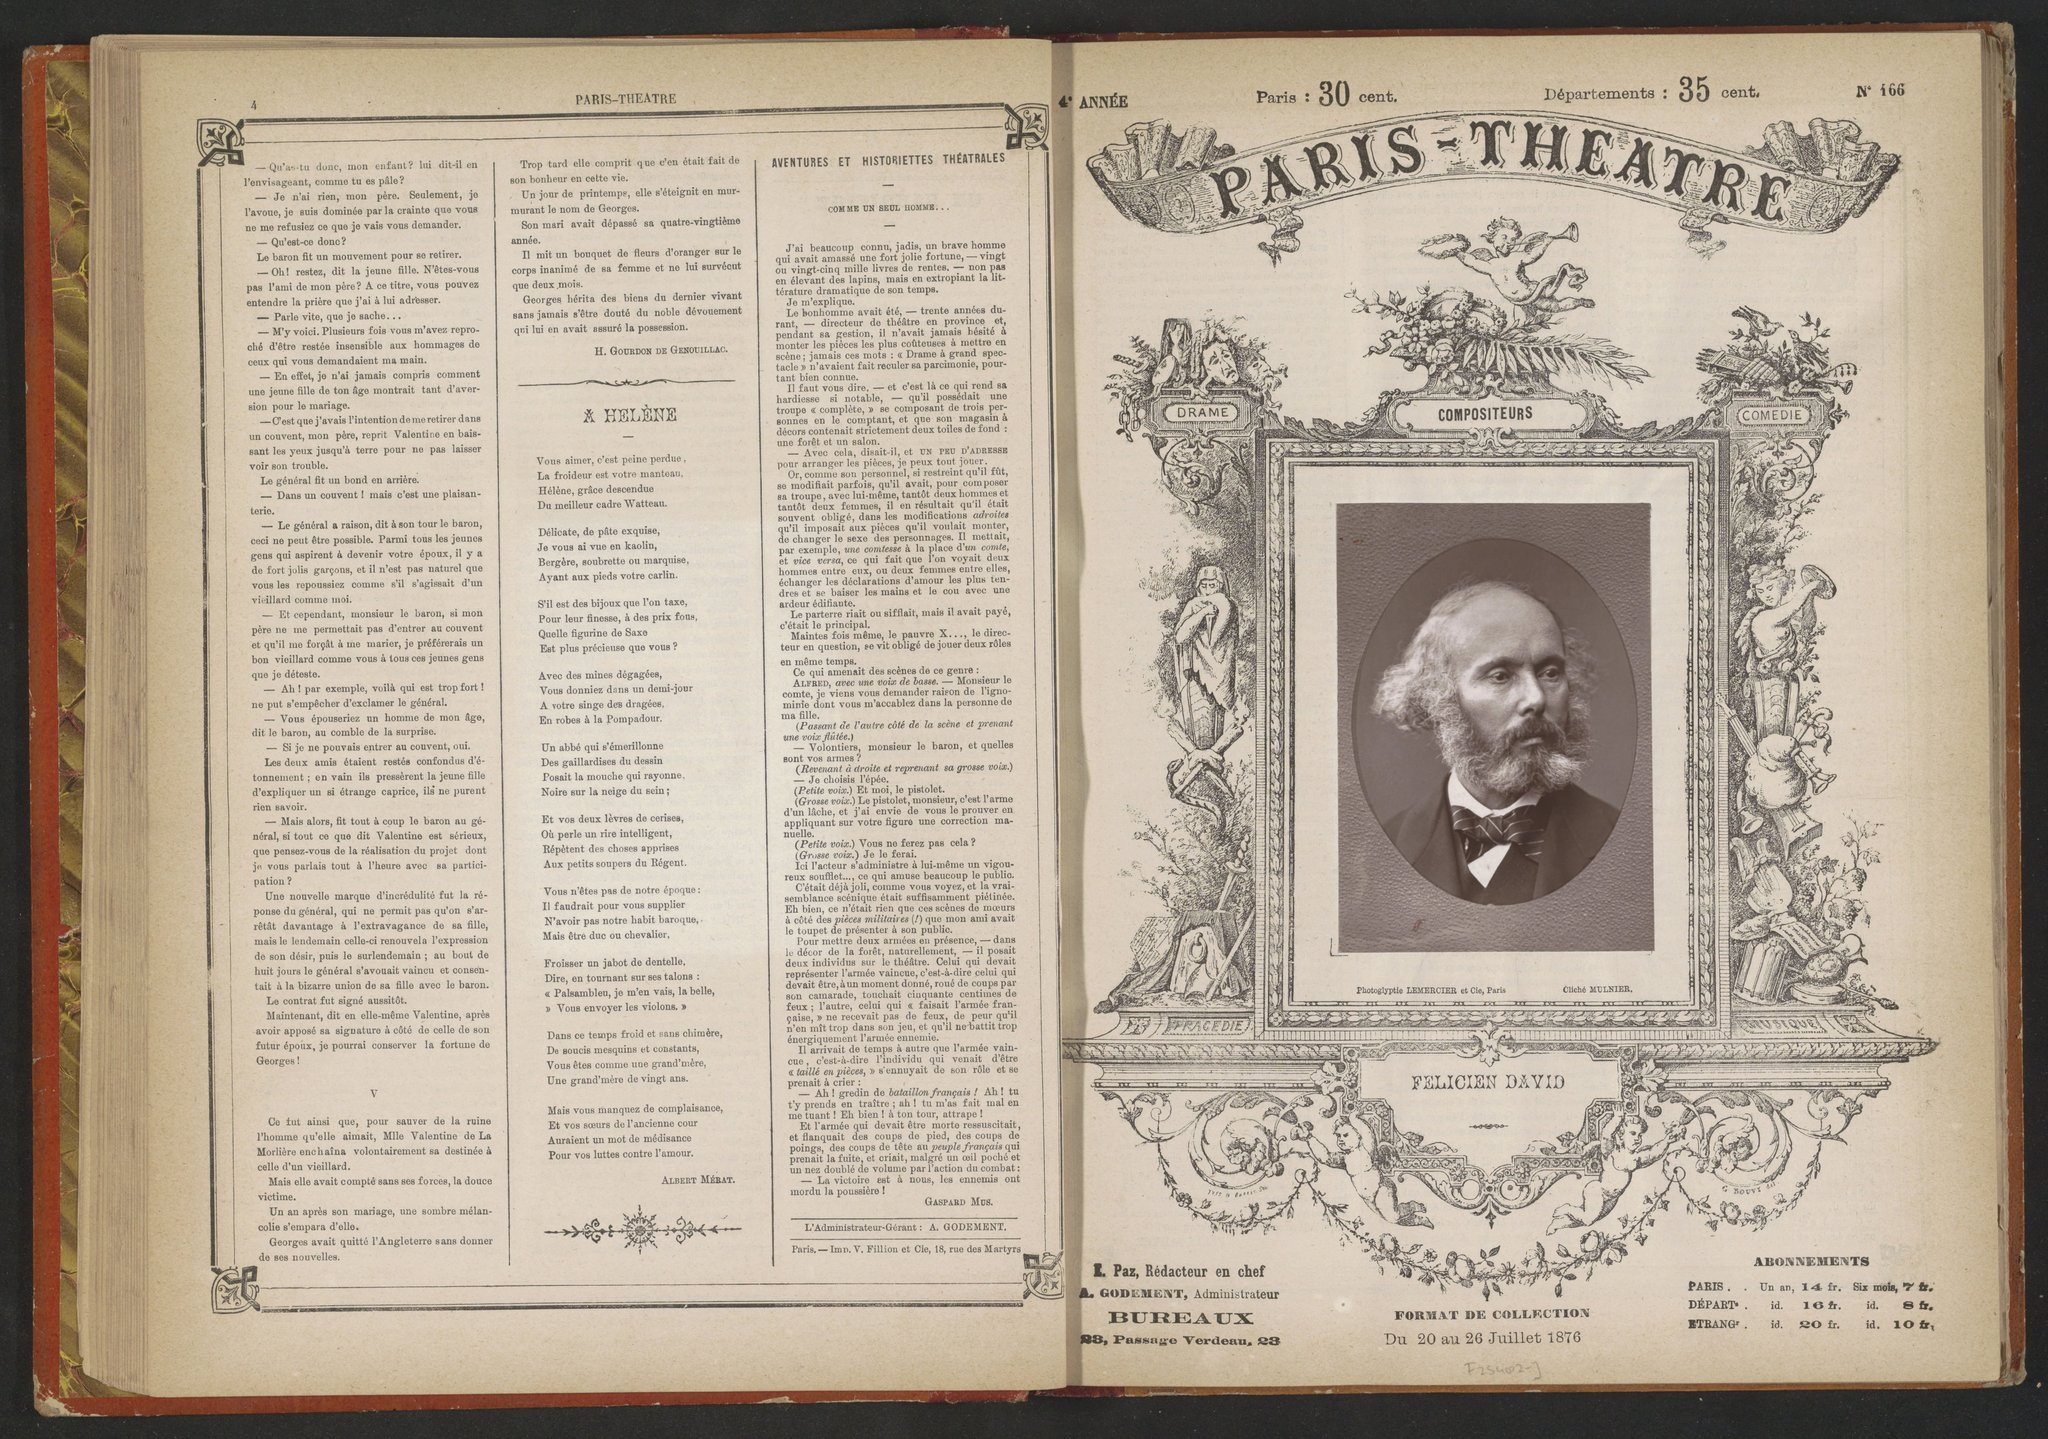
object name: page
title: Portret van Félicien David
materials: paper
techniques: woodburytype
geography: france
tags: composer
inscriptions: number: ‘No 166’, inscription: ‘Du 20 au 26 Juillet 1876’